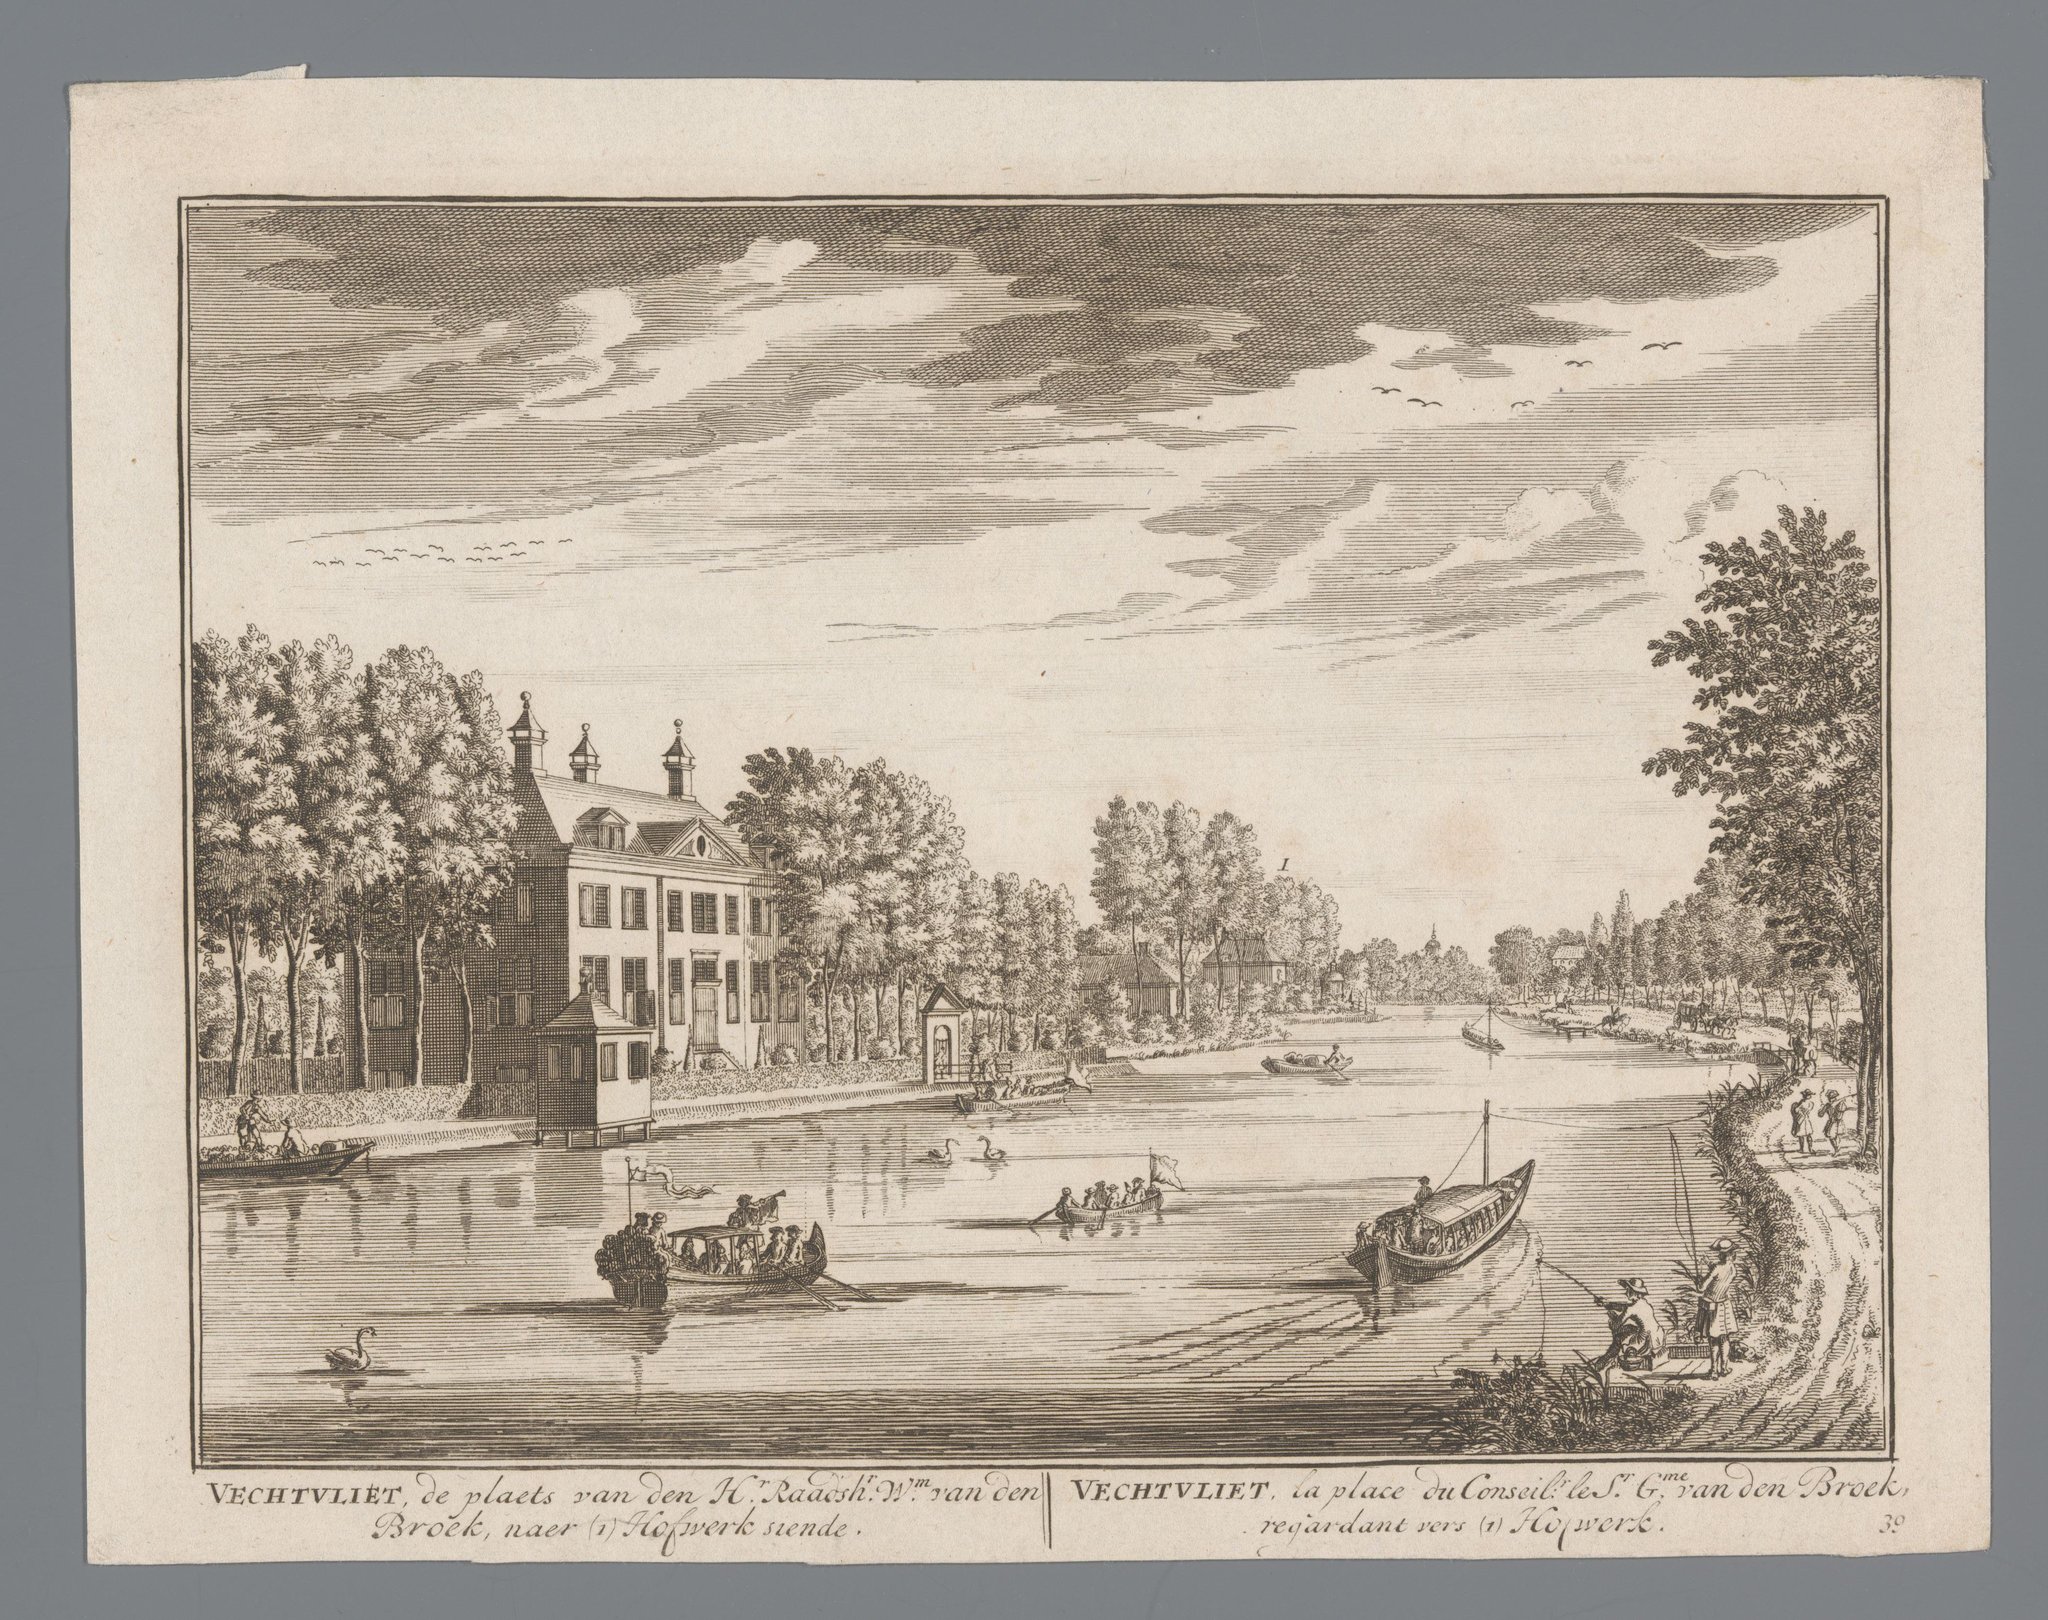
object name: book illustration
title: Gezicht op Vechtvliet aan de Vecht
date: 1719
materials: paper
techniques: etching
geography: amsterdam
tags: rural housing, e.g. country-house, villa, cottage, tow-boat, towing-barge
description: Prent uit: Stopendaal, Daniël. De zegepraalende Vecht, vertoonende verscheidenen gesichten van lustplaatsen, heeren huysen en dorpen, beginnende van Uitrecht en met Muyden besluytende. Amsterdam: Weduwe Nicolaas Visscher, 1719.